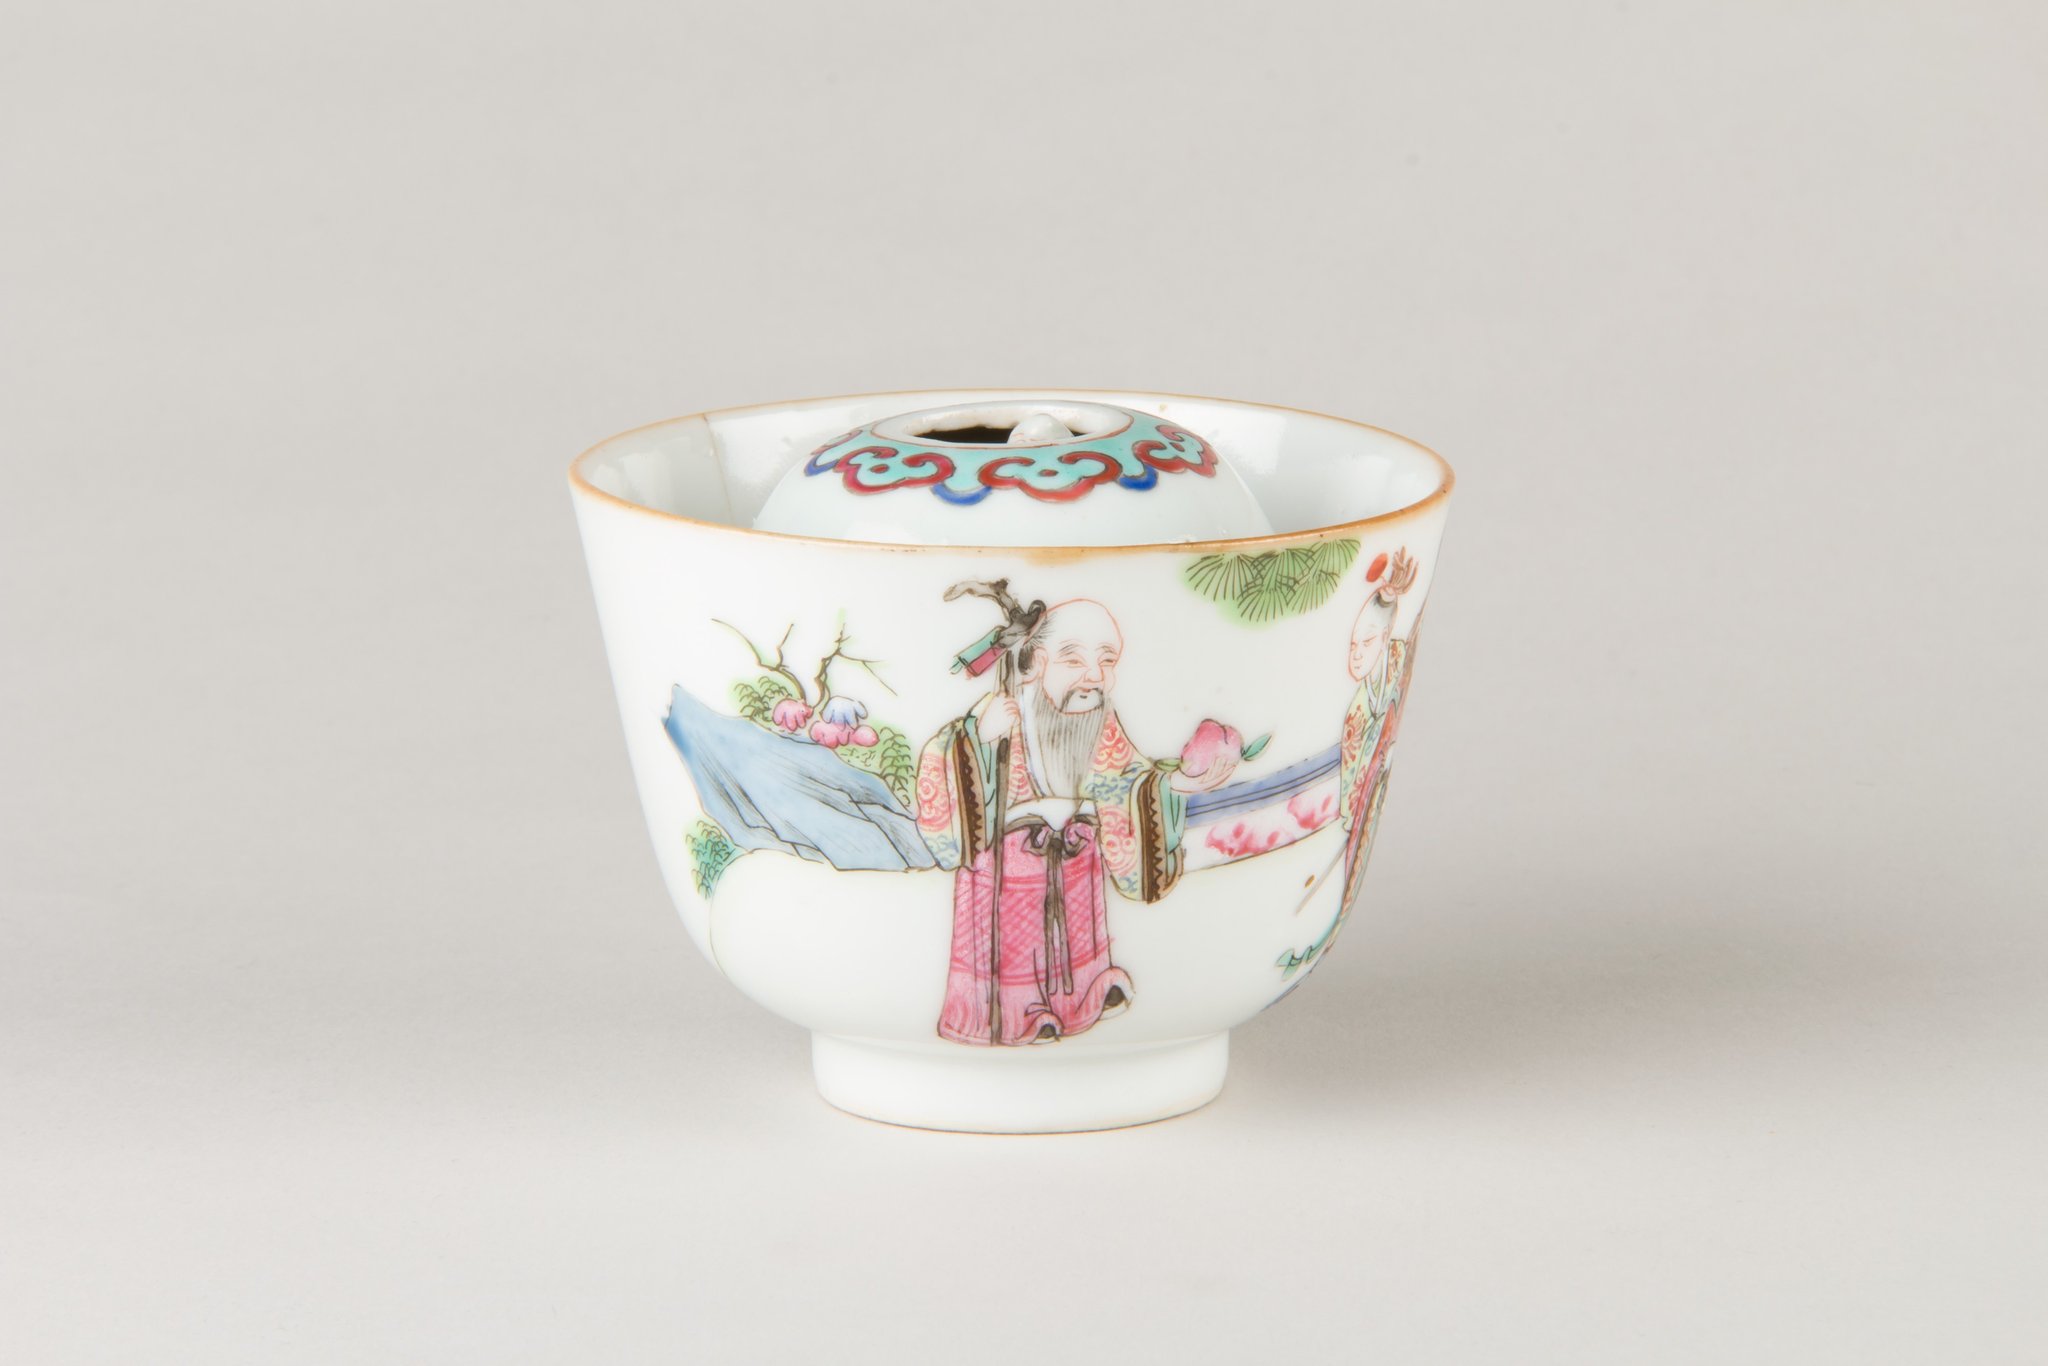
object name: cup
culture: chinese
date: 1801-1850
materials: enamel, porcelain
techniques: overglaze, painting, polychrome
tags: men